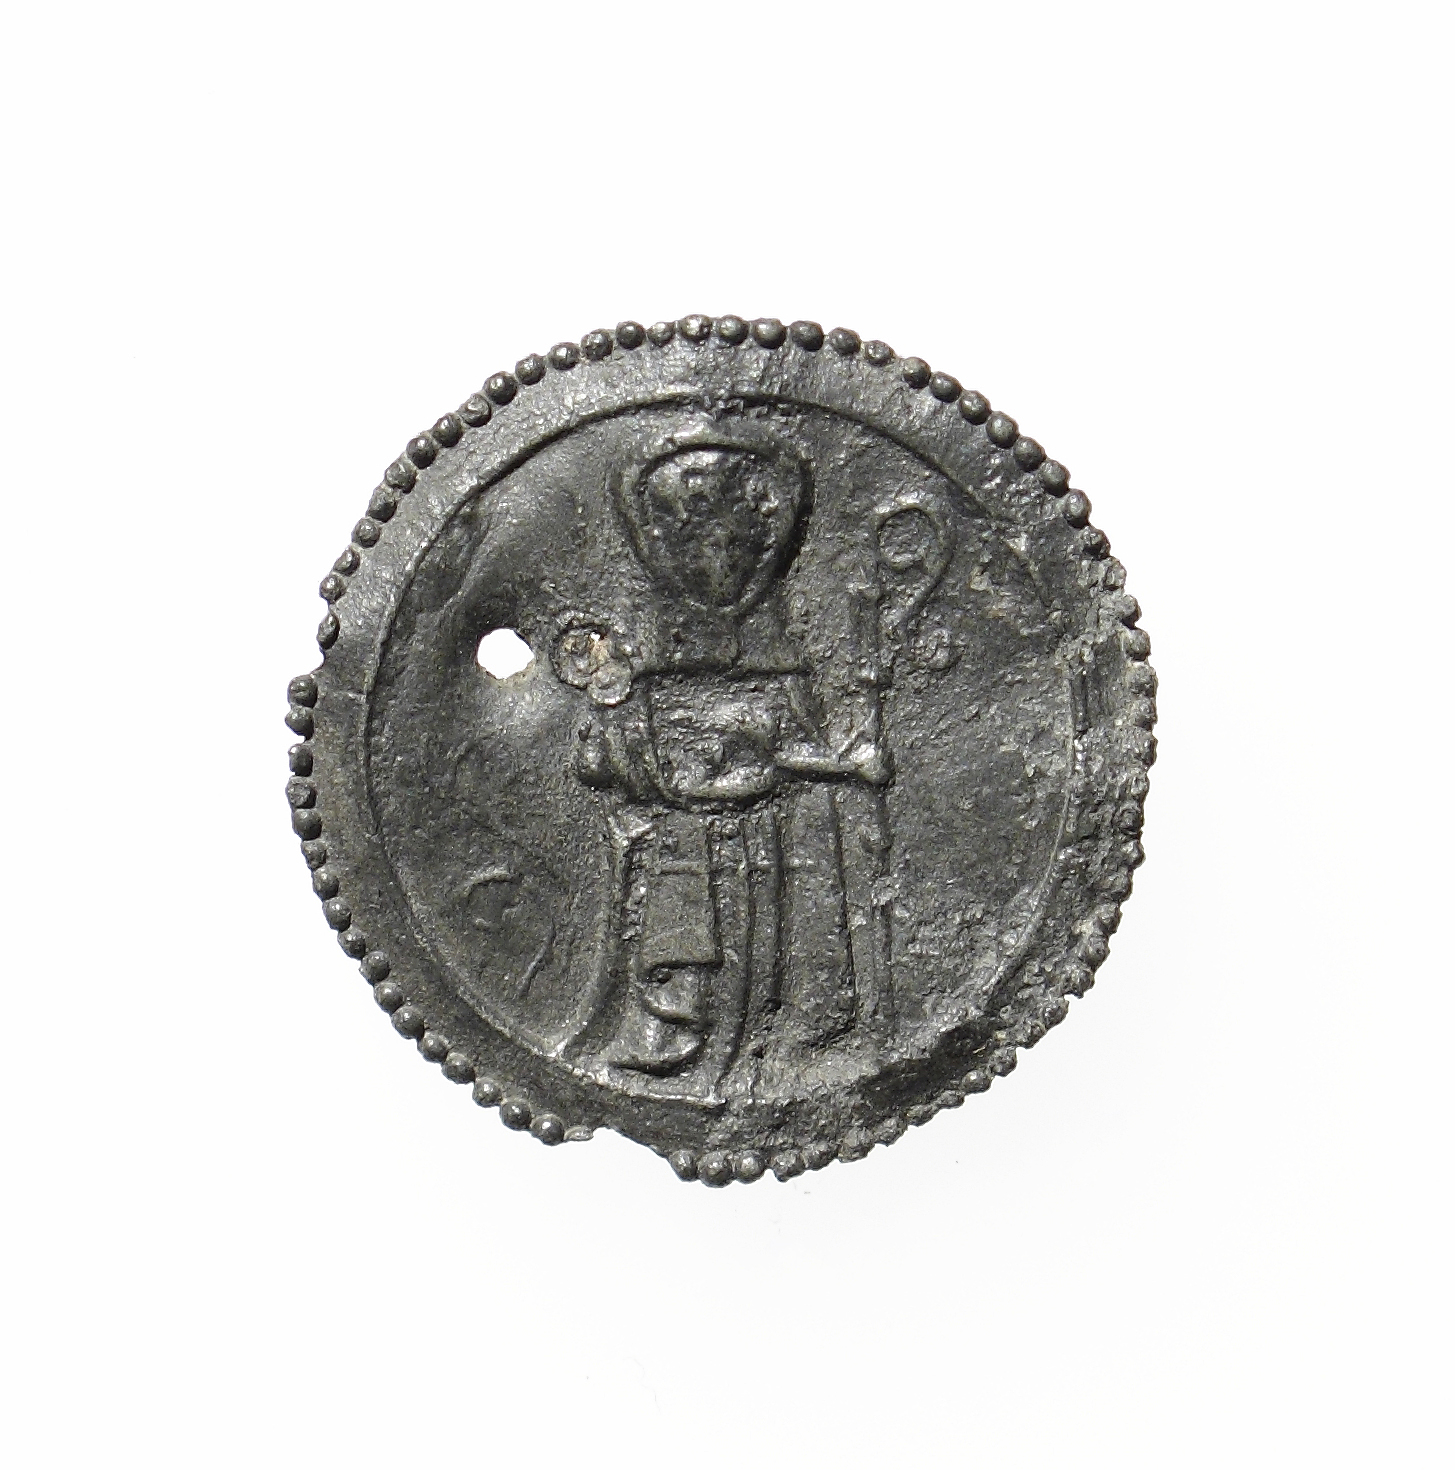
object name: pilgrim's badge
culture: french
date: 1301-1600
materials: lead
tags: saints